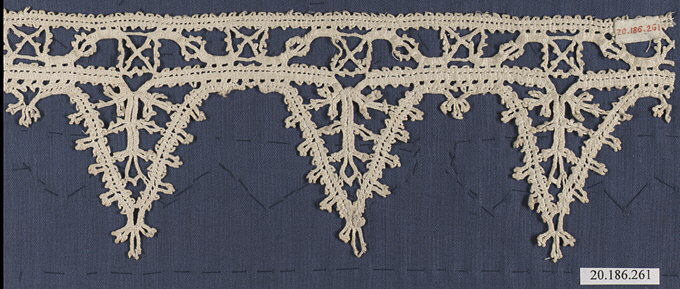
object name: edging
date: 1501-1700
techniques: lace